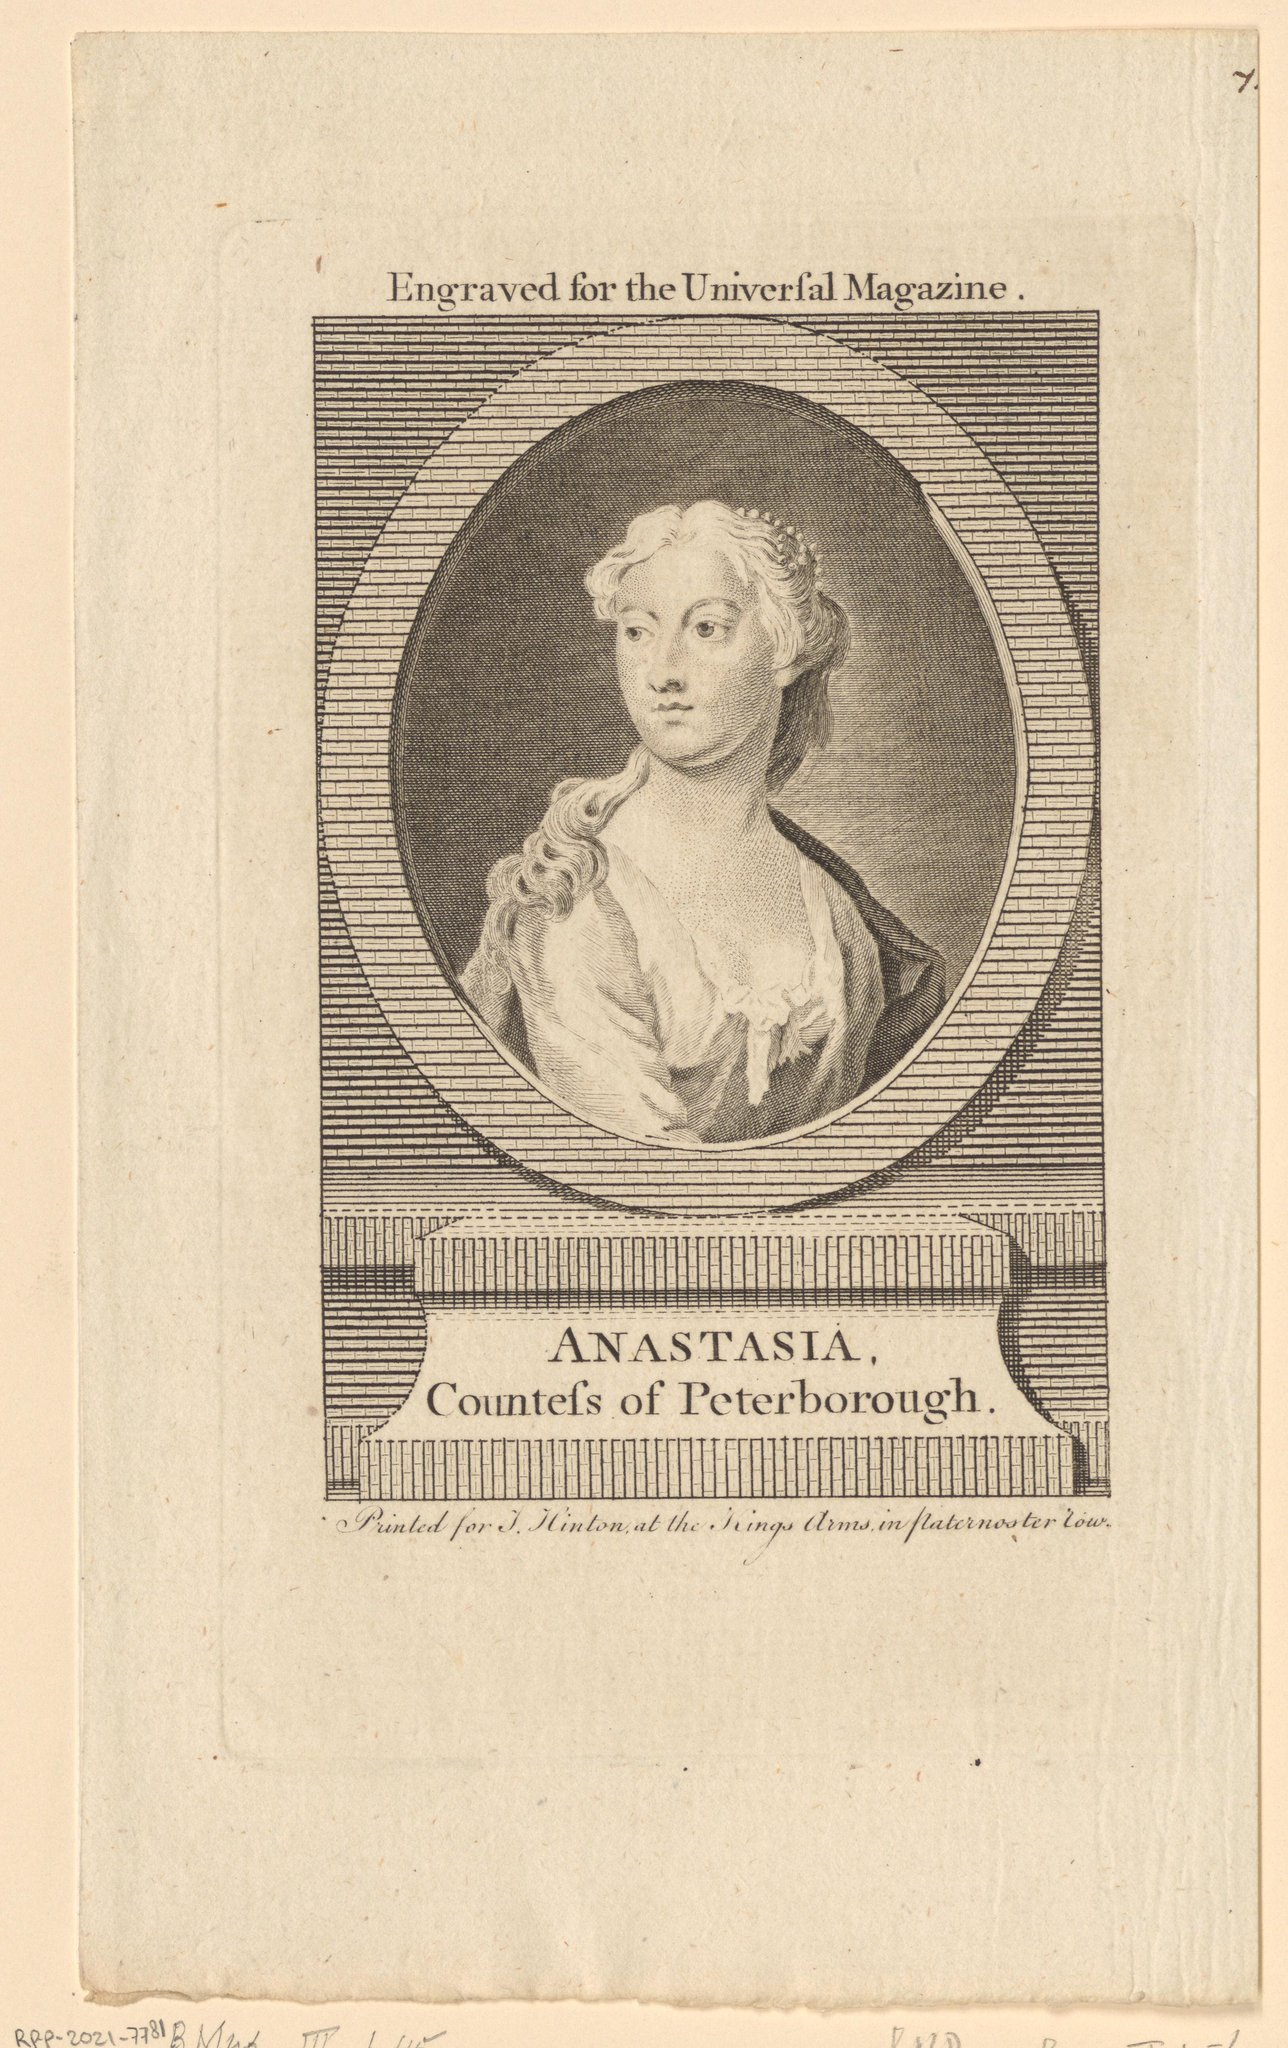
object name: print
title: Portret van Anastasia Robinson, gravin van Peterborough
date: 1777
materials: paper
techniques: engraving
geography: london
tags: adult woman, historical persons, opera-singer (female)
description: Prent uit: The Universal Magazine of Knowledge and Pleasure 60 (1777), januari 1777.